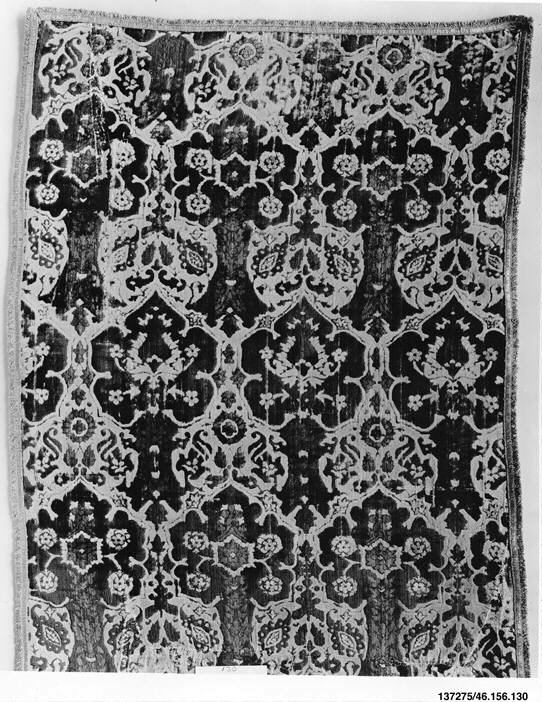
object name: piece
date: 1501-1600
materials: silk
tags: leaves